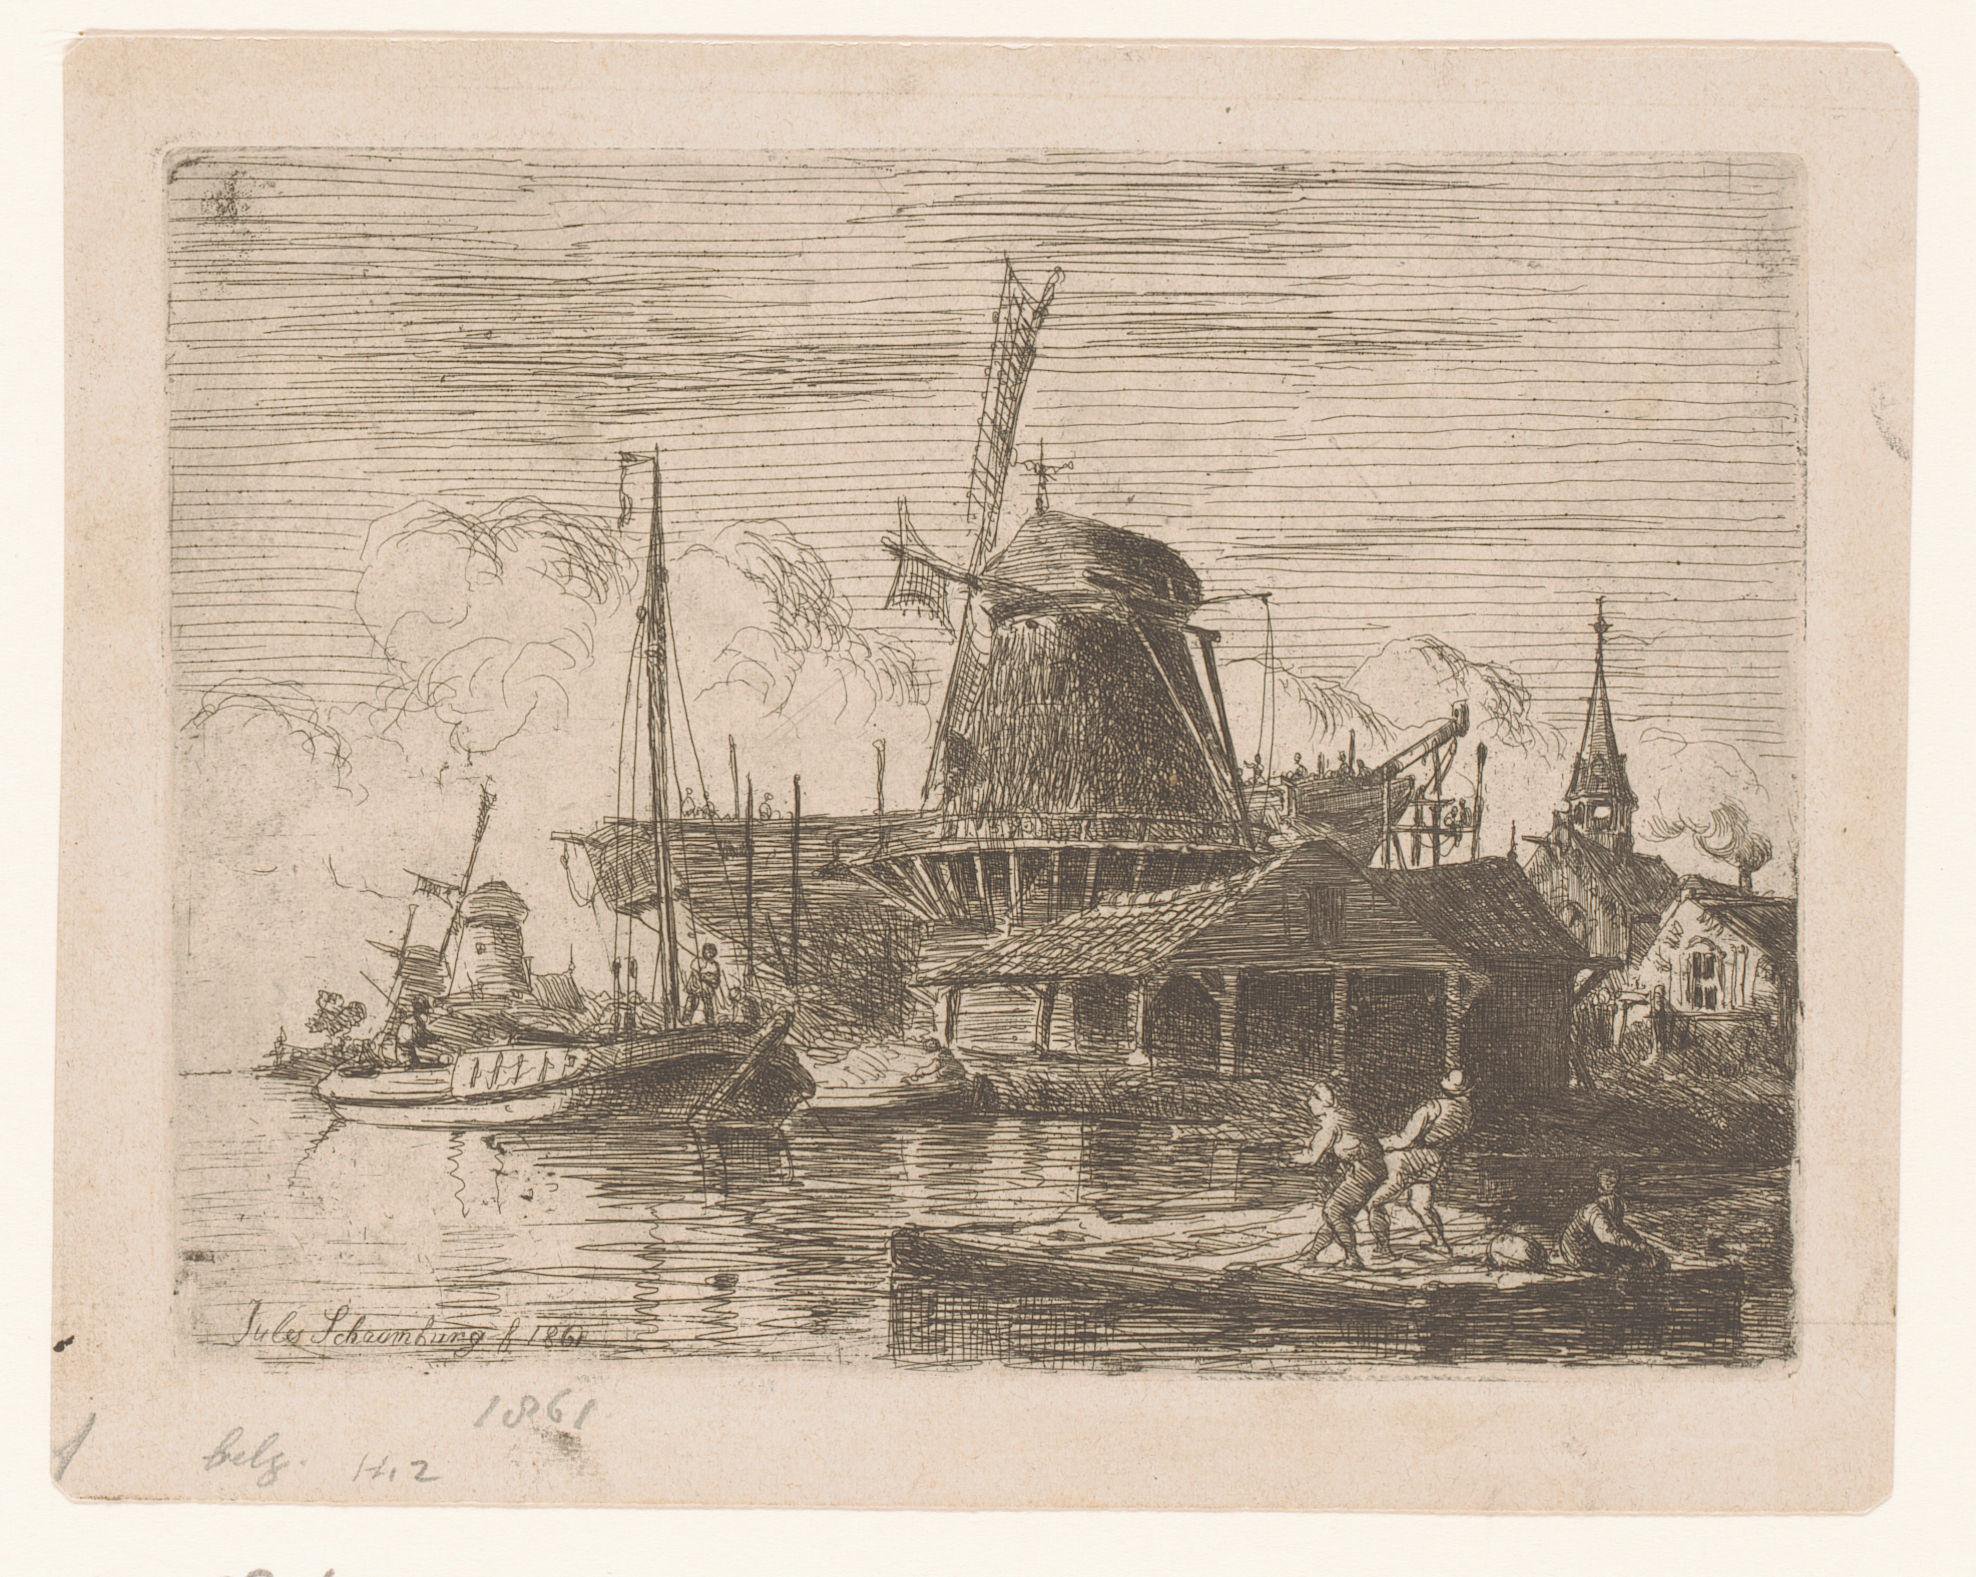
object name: print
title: Molens aan het water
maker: jules schaumburg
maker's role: print maker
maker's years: 1839-1886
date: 1861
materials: paper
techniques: etching, intaglio, letterpress printing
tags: village, landscapes with waters, waterscapes, seascapes (in the temperate zone) (+ landscape with figures, staffage), windmill in landscape (+ city(-scape) with figures, staffage)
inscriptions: collector's mark: Lugt 2228